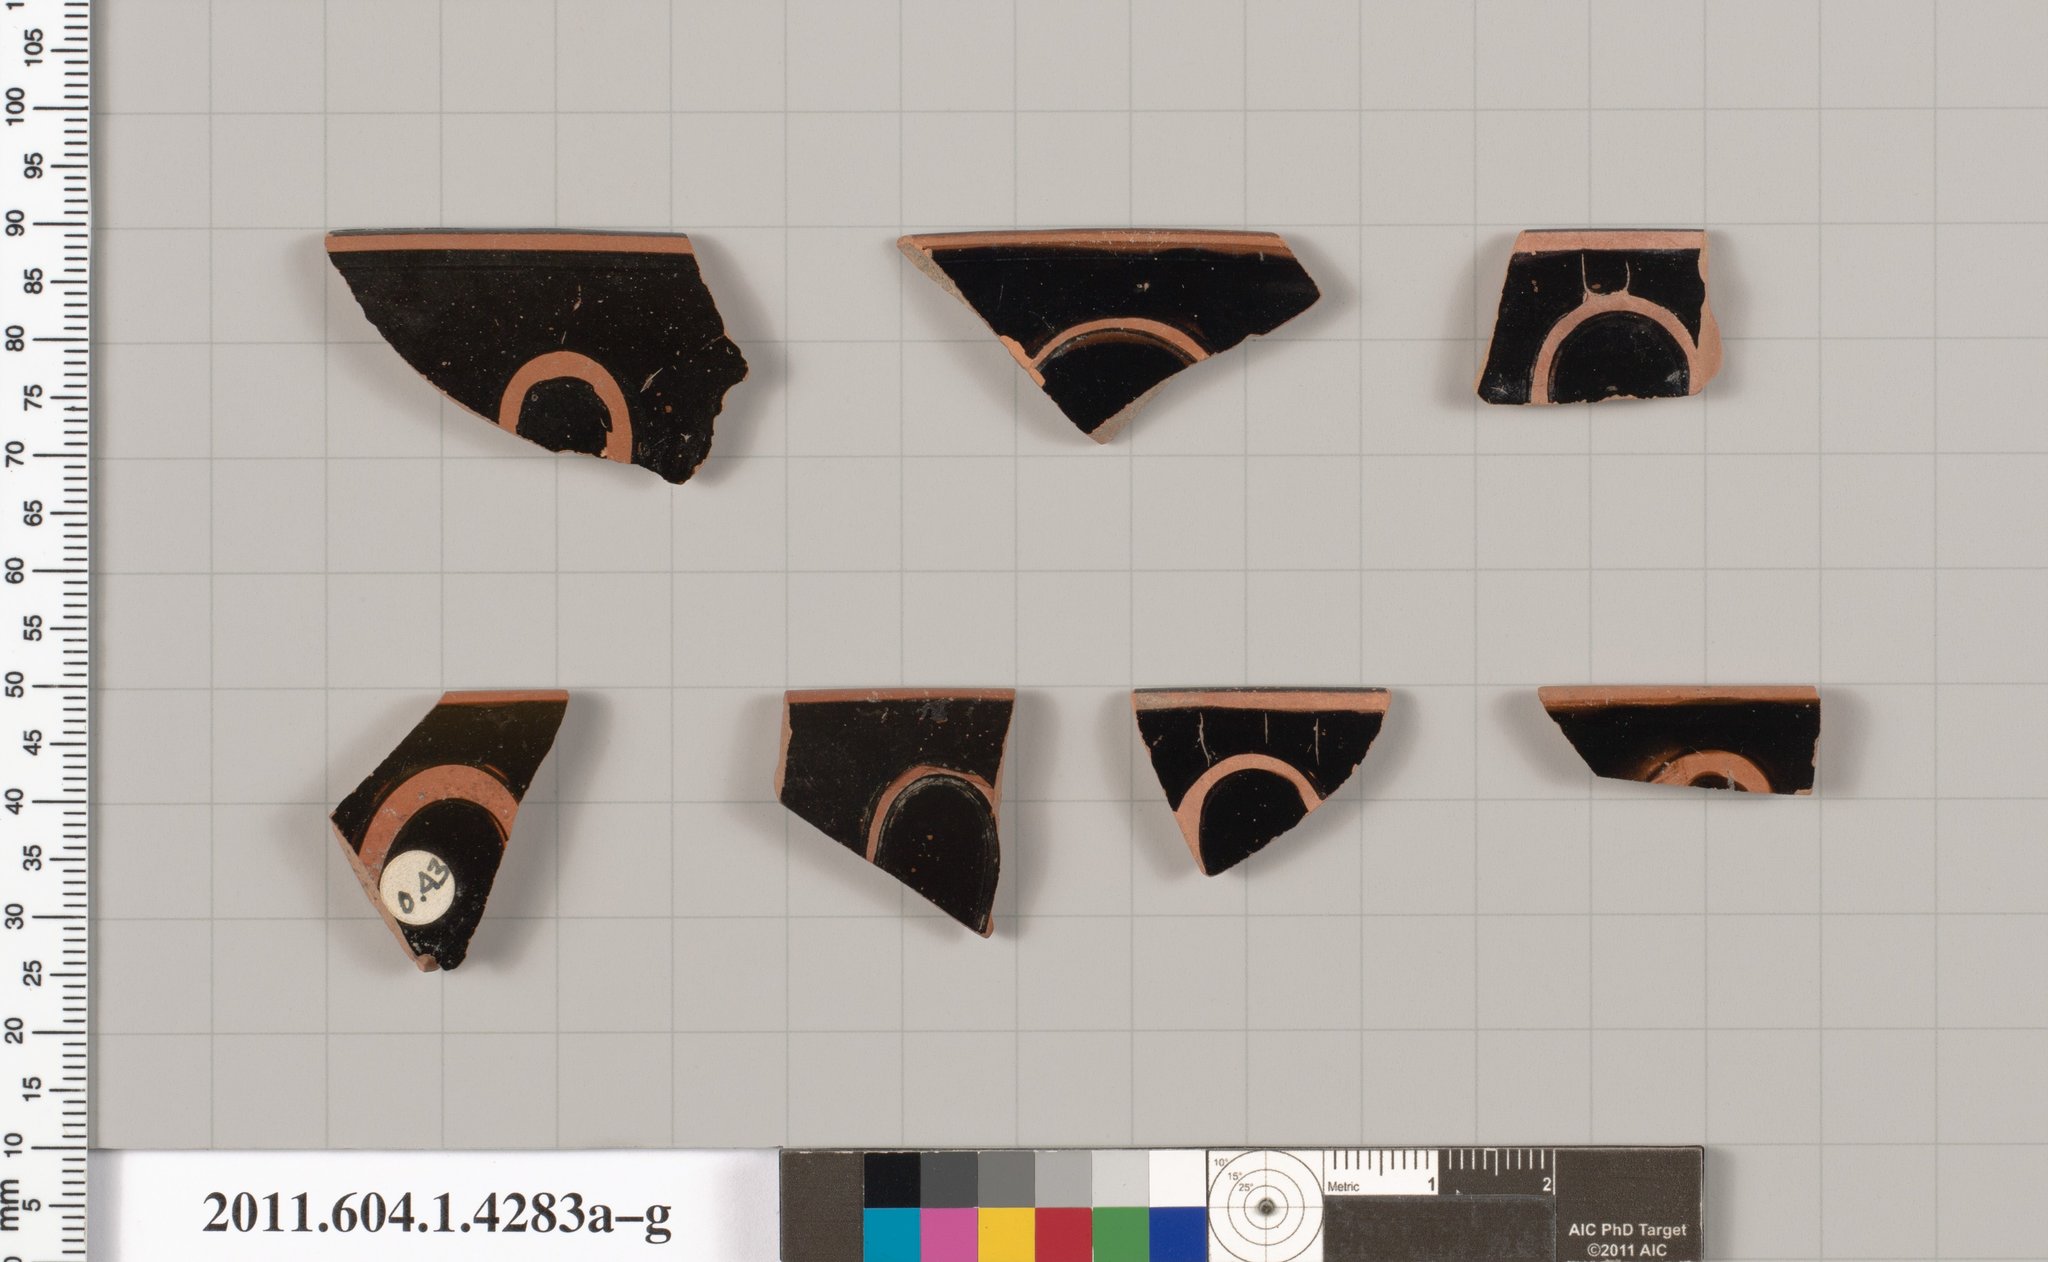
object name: kylix fragment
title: Terracotta rim fragments of kylikes (drinking cups)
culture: greek, attic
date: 500-451 BCE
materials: terracotta